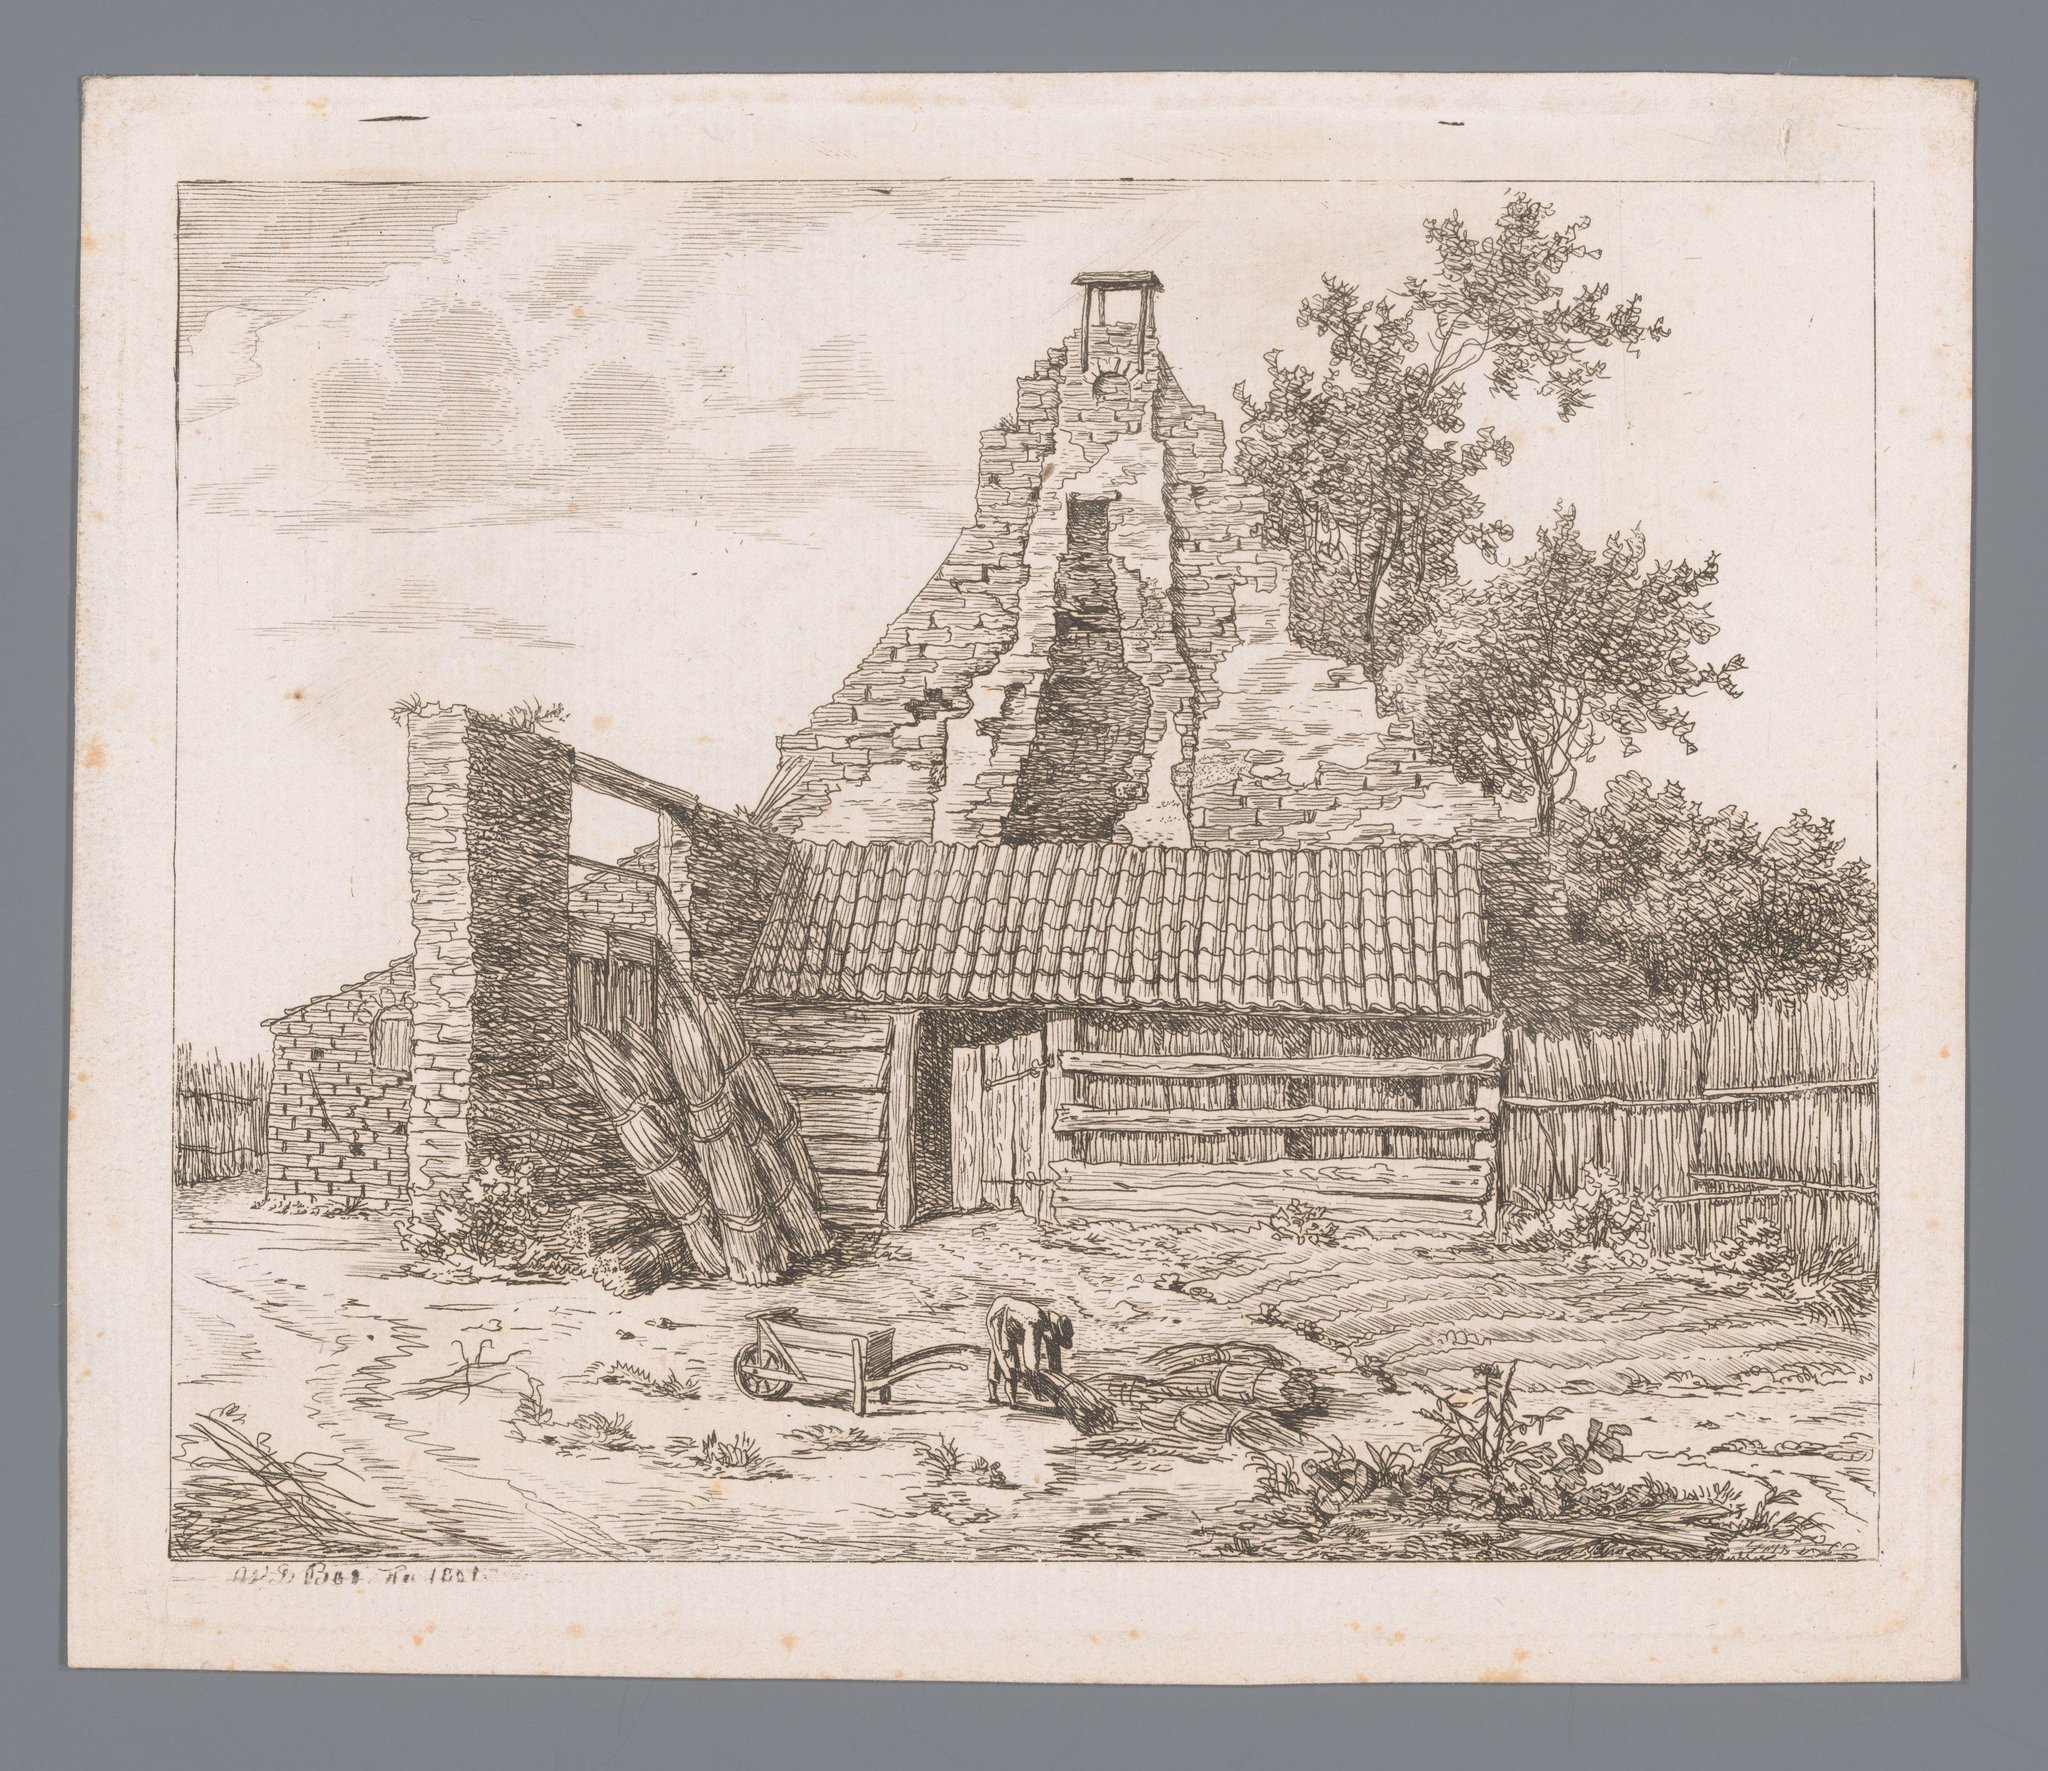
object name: print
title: Rietsnijder voor de ruïne van Huis Snaatburg te Maarssen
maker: anthonie van den bos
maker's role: draughtsman, print maker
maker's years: 1763-1838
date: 1801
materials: paper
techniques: etching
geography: netherlands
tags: ruin of a dwelling, house, castle, etc., reeds, rushes ~ building material, maarssen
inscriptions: collector's mark: Lugt 2228